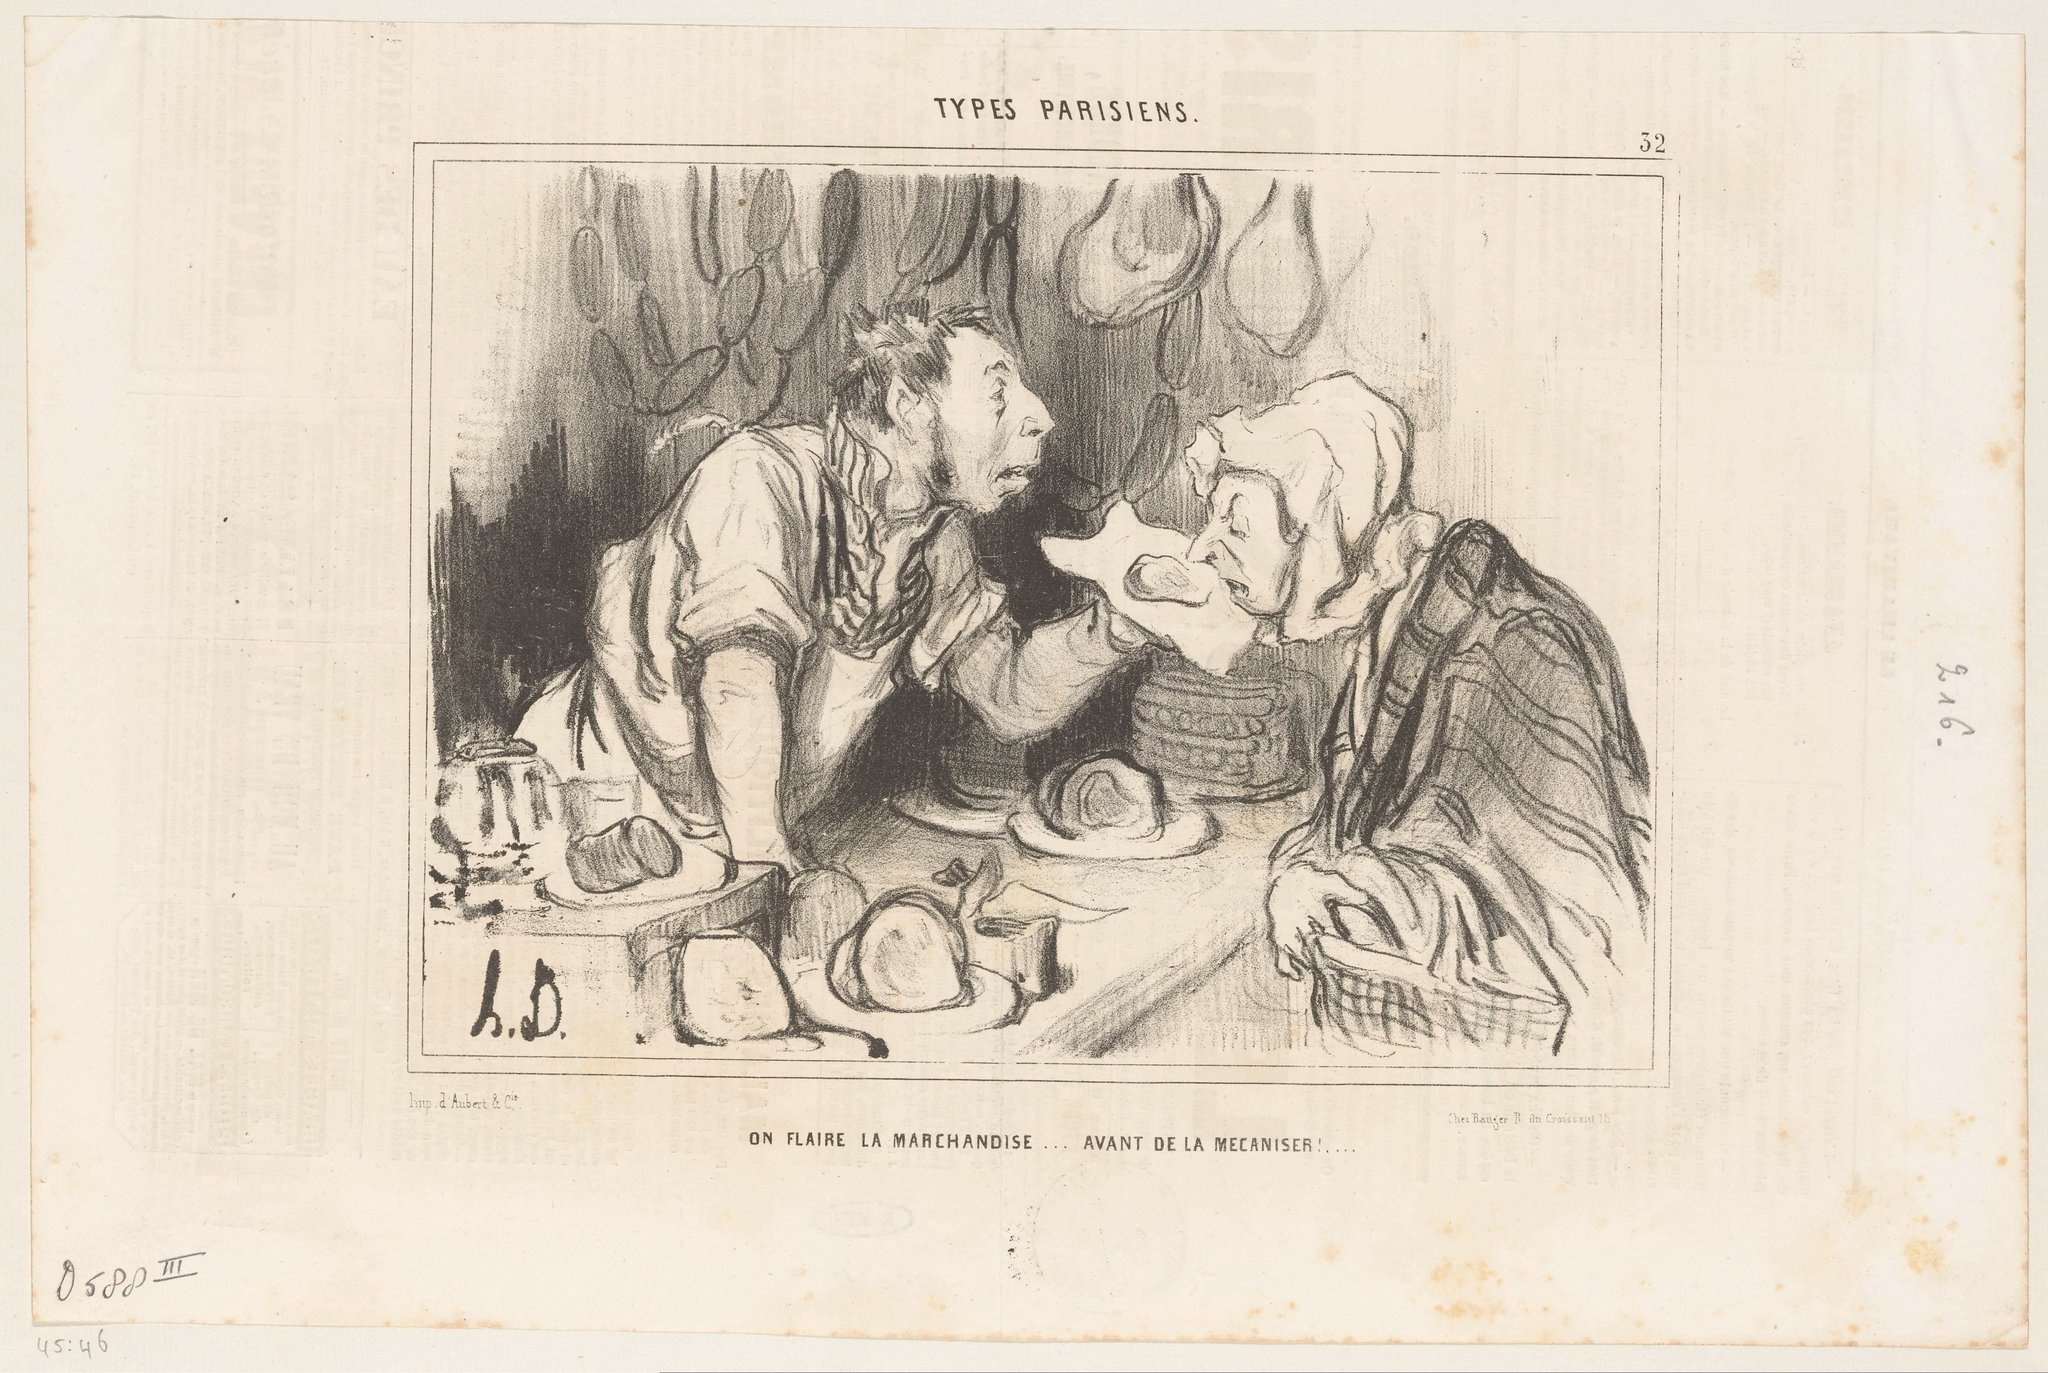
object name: cartoon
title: Types Parisiens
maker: honoré daumier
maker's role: draughtsman, painter, print maker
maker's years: 1808-1879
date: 1842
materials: paper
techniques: letterpress printing, lithograph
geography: paris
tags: caricatures (human types), smell, smelling (one of the five senses), old woman, butcher, slaughterman, paris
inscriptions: stamp: ‘Timbre Royal Seine, 3 c.’, collector's mark: Lugt 2228a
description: Prent uit: Le Charivari, 27 juli 1842. Prent voor het eerst gebruikt in: La Caricature, nr. 17, 24 februari 1839.